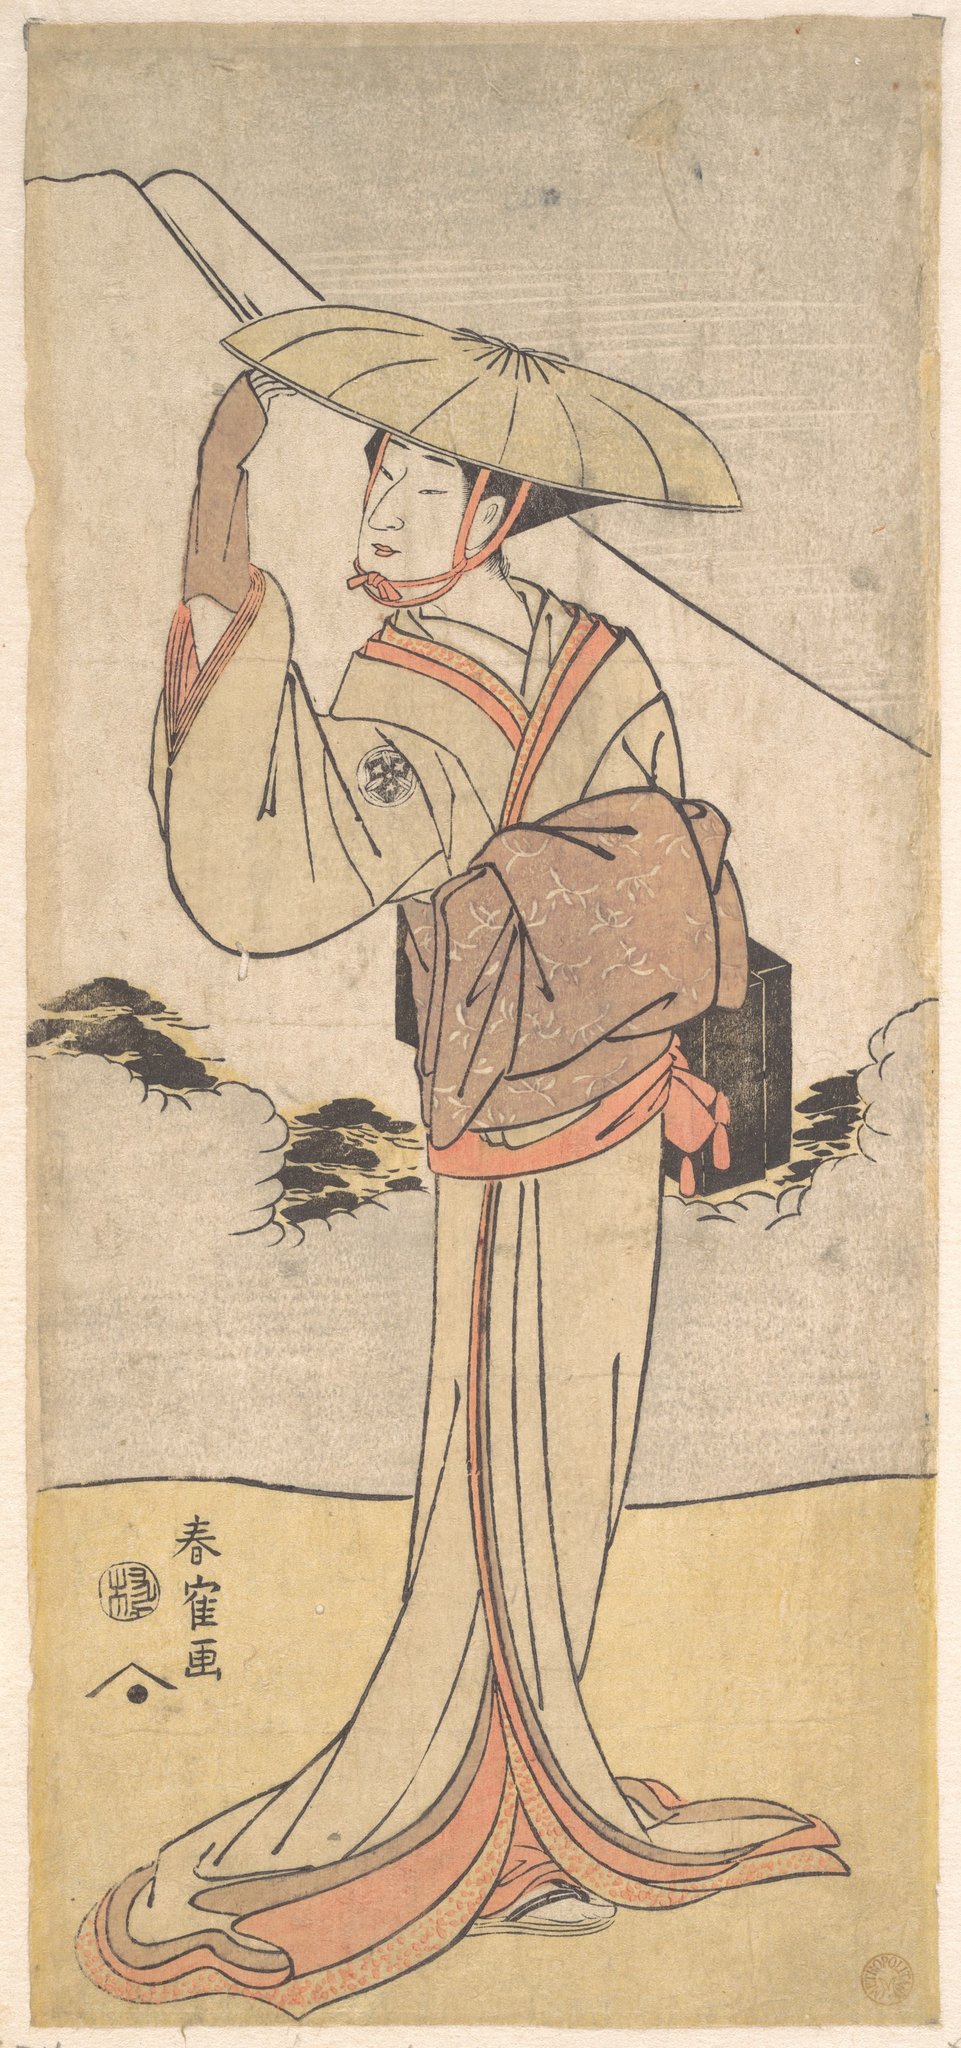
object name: print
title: Nakamura Noshio II in the Role of Imayō uta Bikuni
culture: japanese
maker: katsukawa shunkaku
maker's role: artist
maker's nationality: japanese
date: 1796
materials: ink, paper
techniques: woodblock print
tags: hats,men,actors